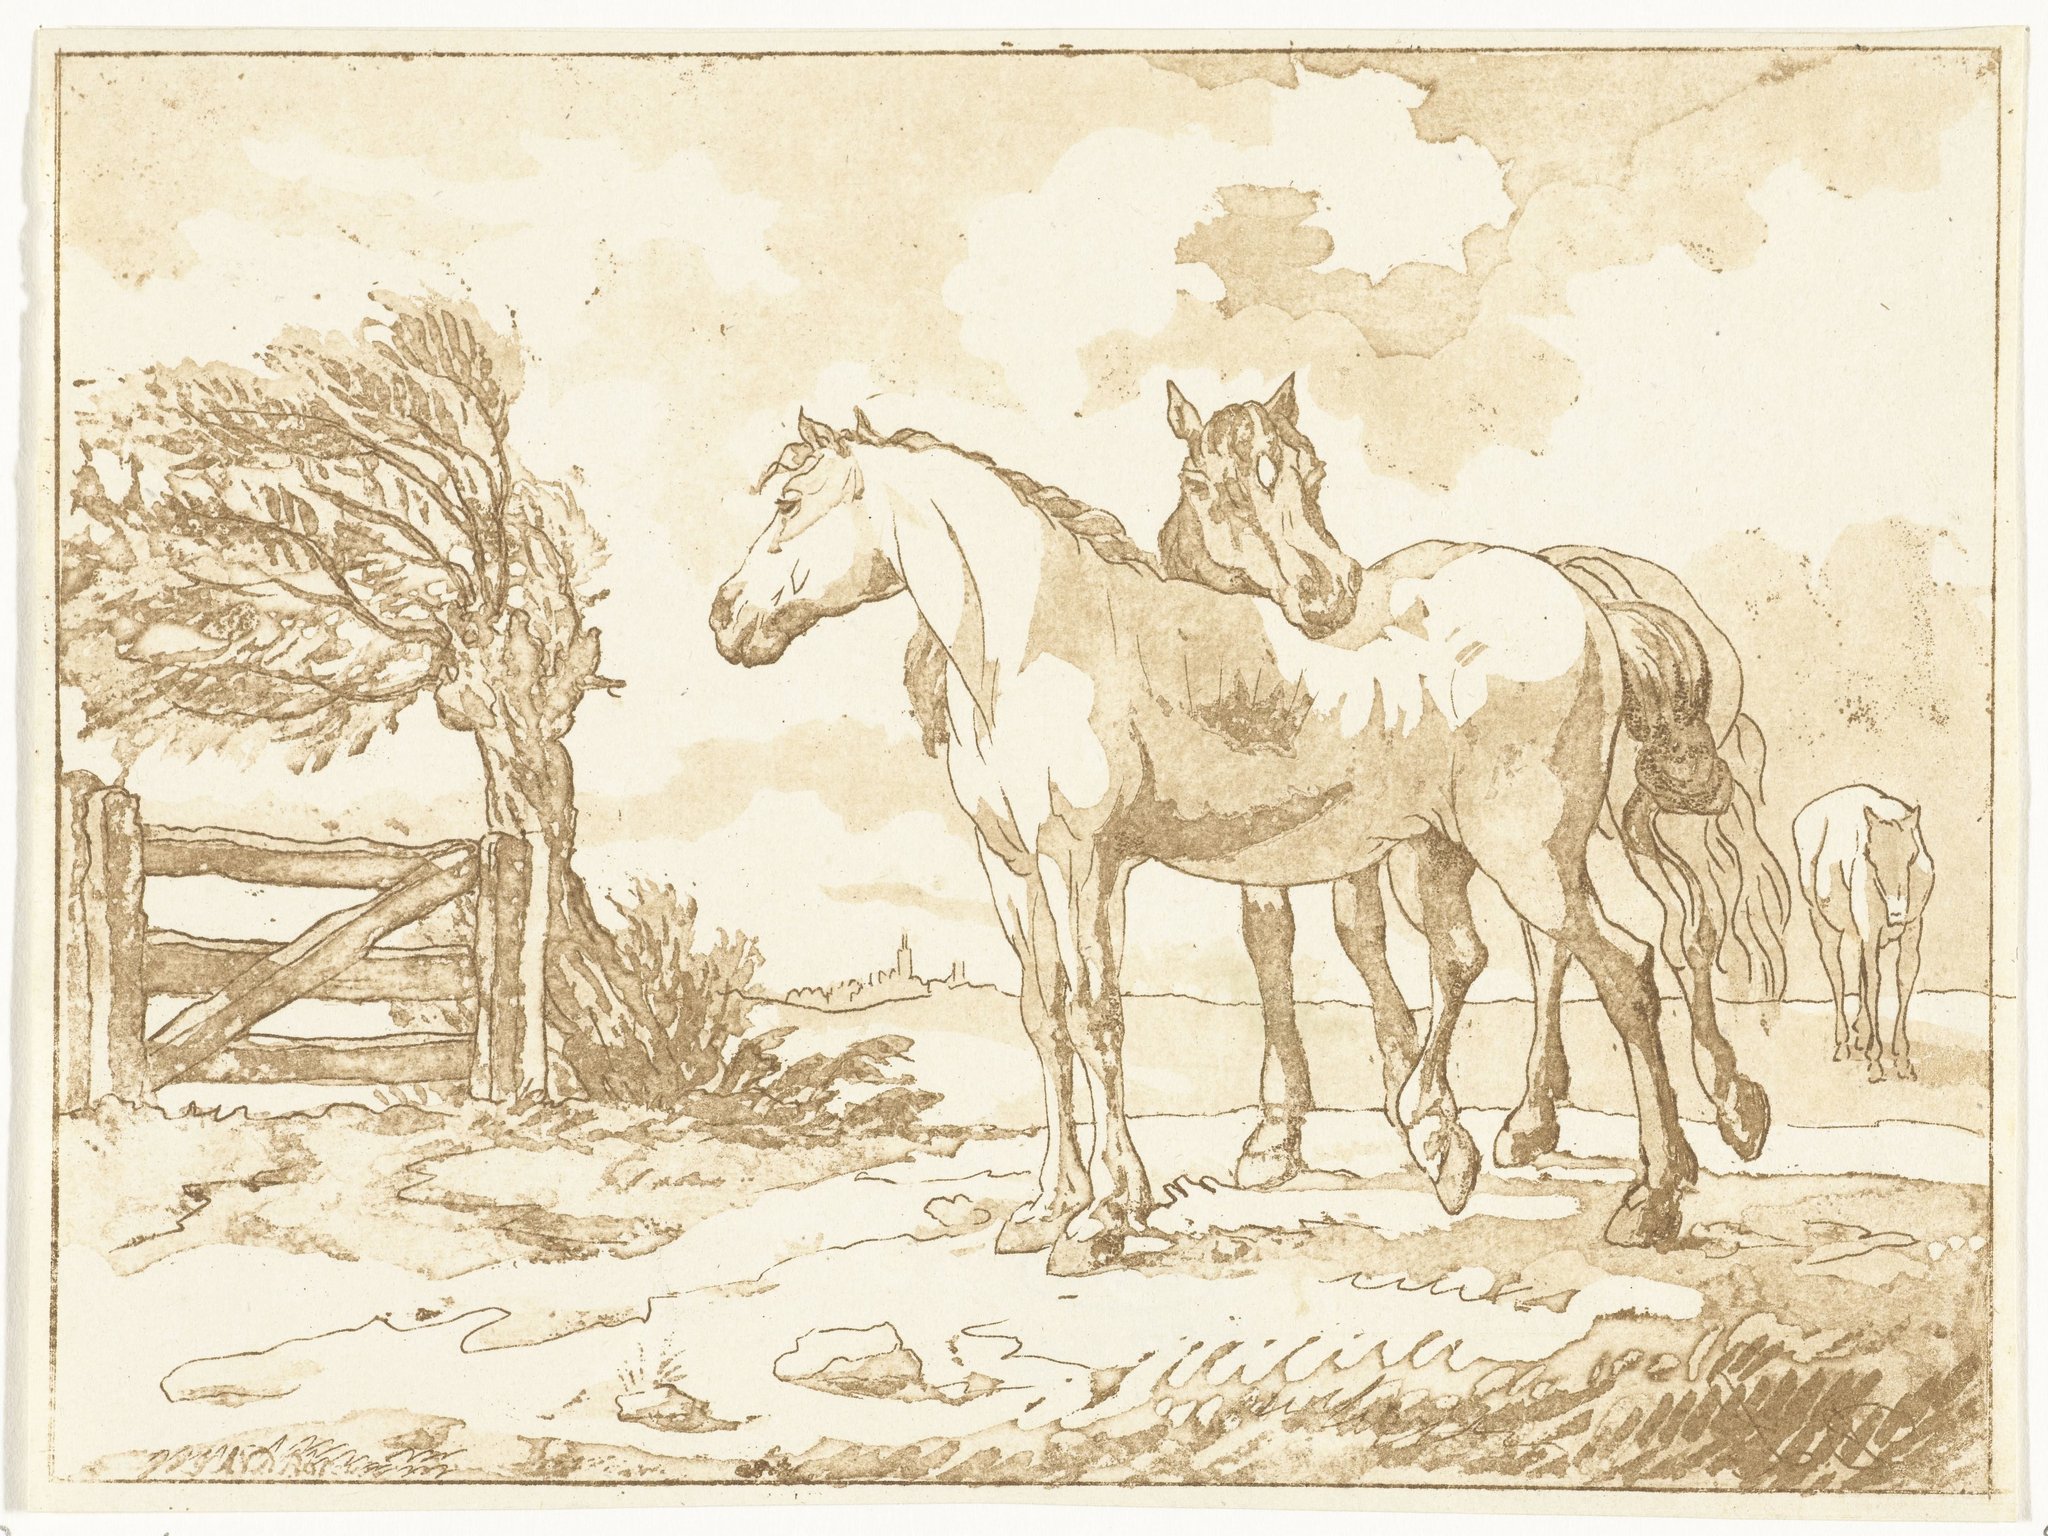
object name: print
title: Paarden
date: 1778-1838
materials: paper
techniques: printmaking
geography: netherlands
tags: horse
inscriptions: collector's mark: Lugt 2228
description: Twee paarden bij een hek met een knotwilg. Op de achtergrond een derde paard en in de verte een dorp.